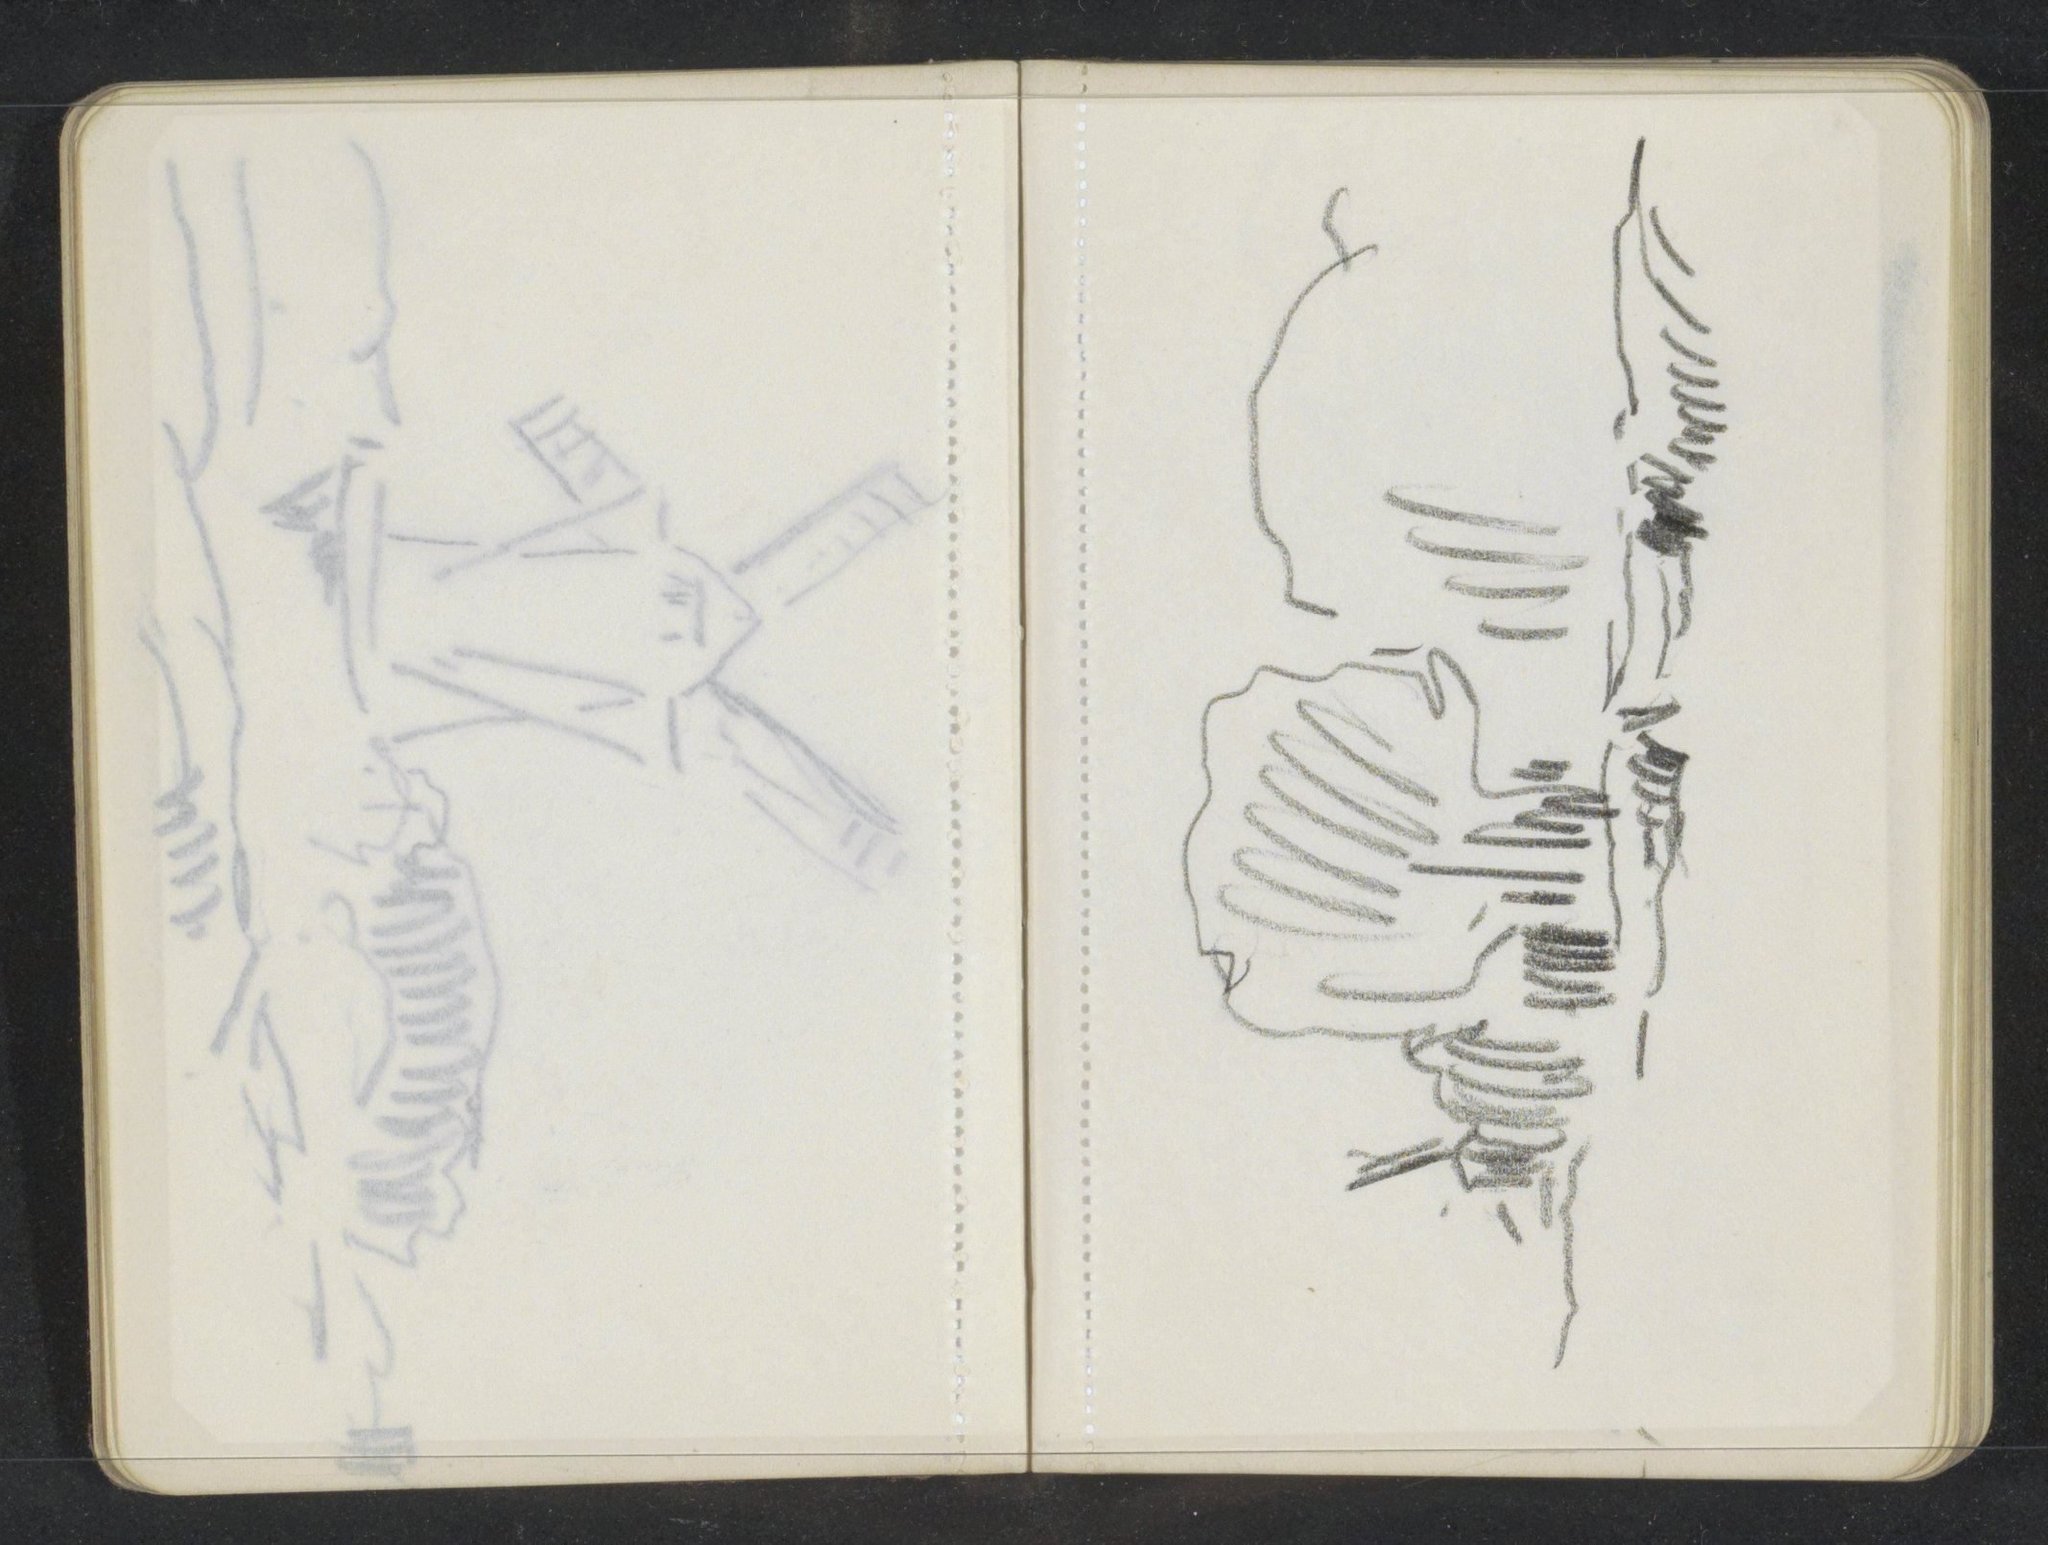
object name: sketchbook leaf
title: Landschap met bomen en een molen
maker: alexander shilling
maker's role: draughtsman, print maker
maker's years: 1859-1937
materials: chalk, paper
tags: trees, windmill in landscape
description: Blad 18 recto uit een schetsboek met 91 bladen.